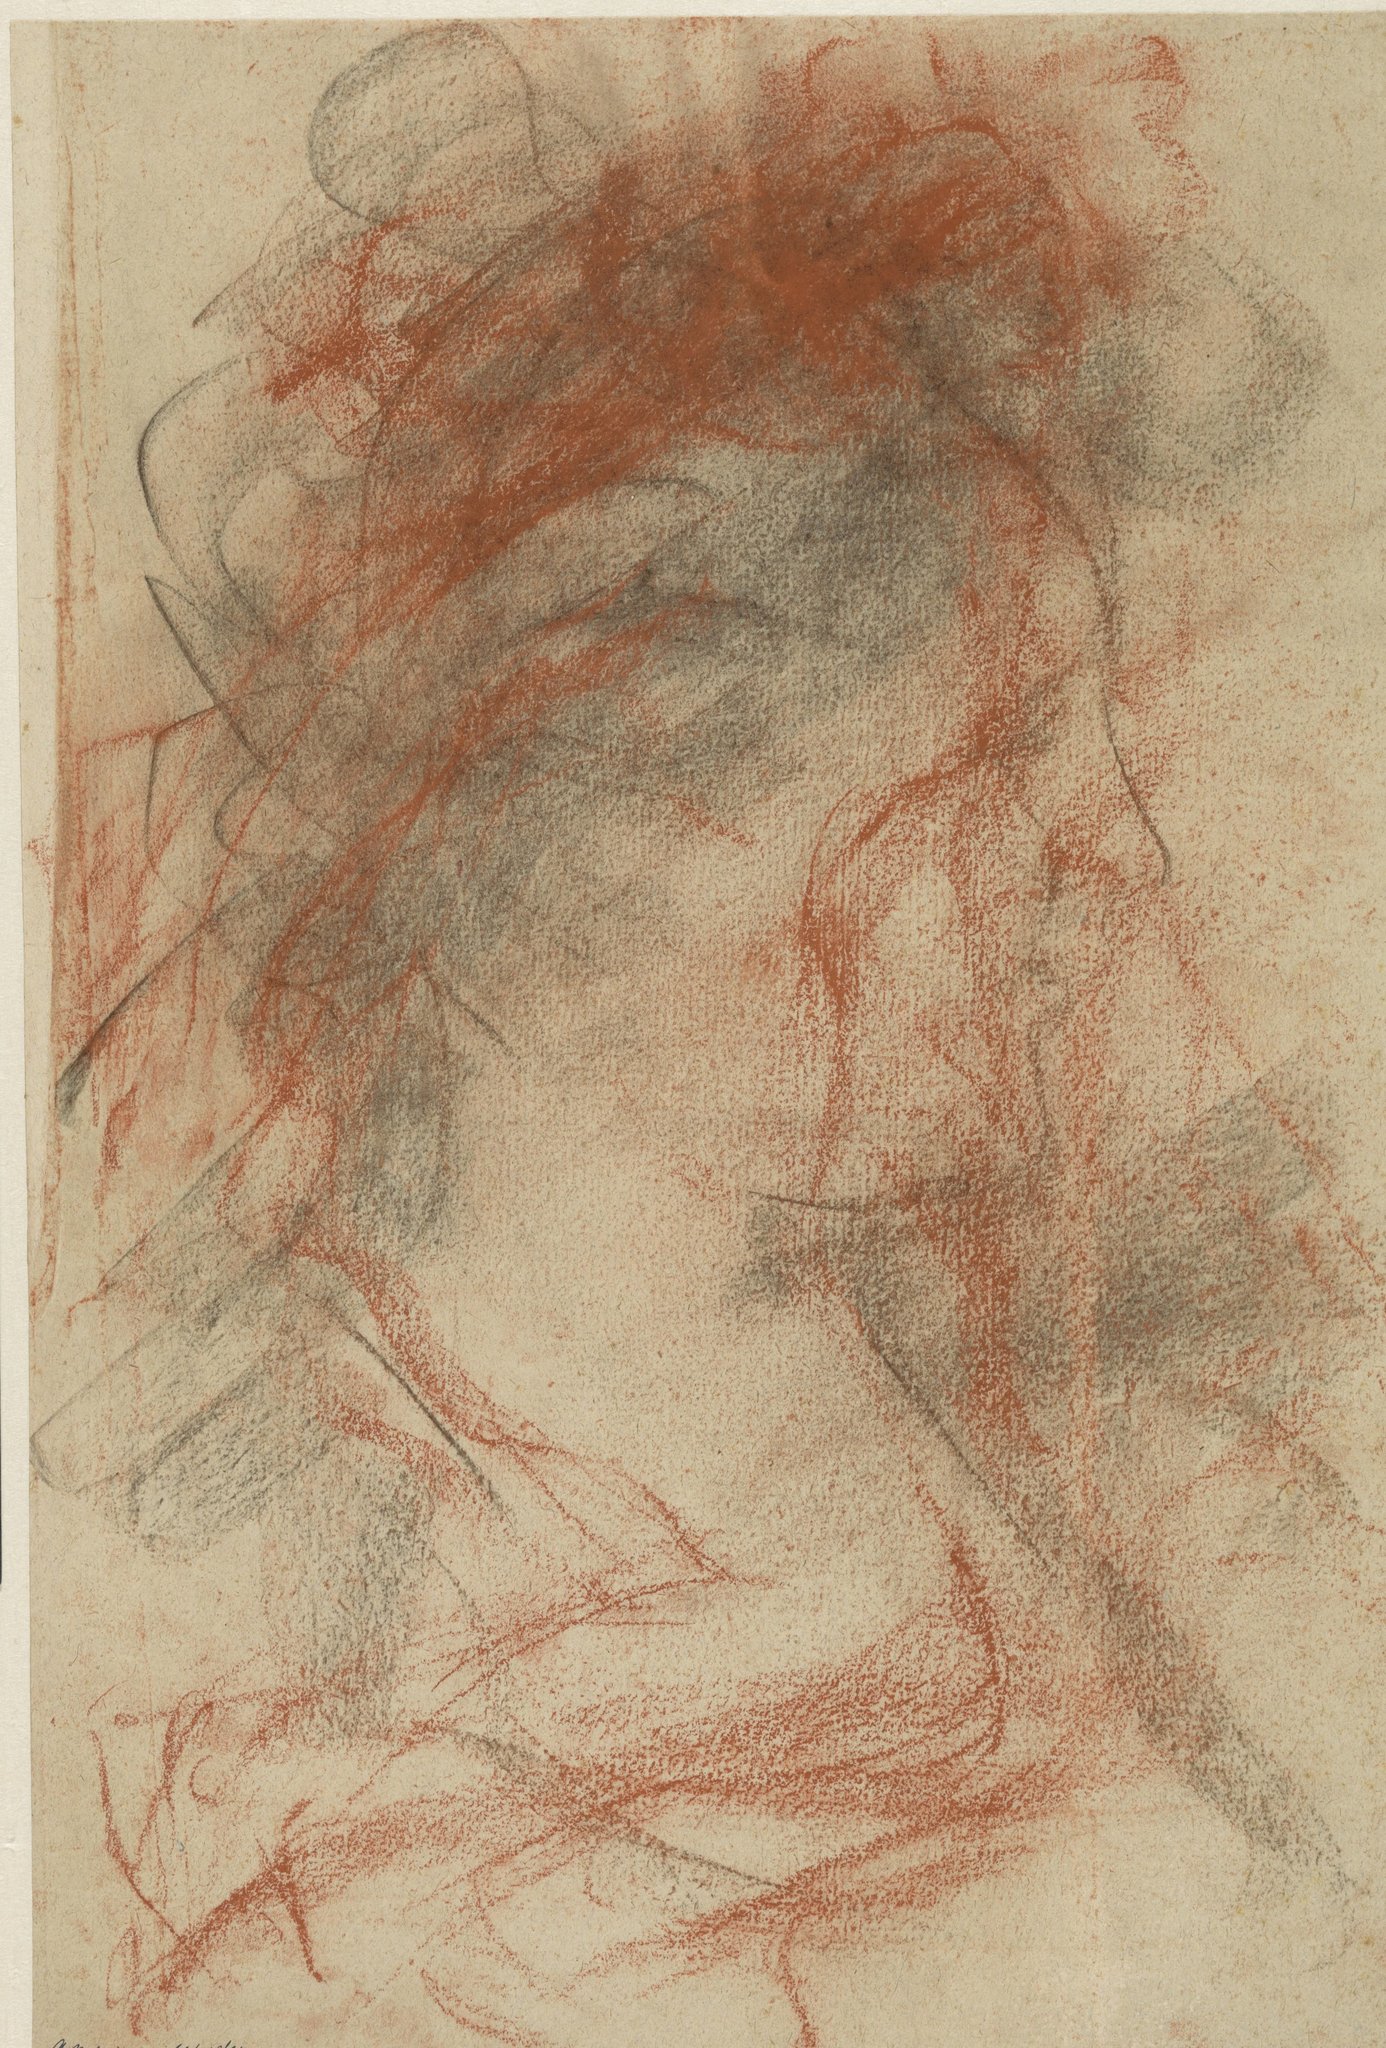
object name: drawing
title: Profielkop naar rechts van een dame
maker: antonio mancini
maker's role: draughtsman, painter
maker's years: 1852-1930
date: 1862-1930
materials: charcoal, paper, pastel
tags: head (human), female sex; woman